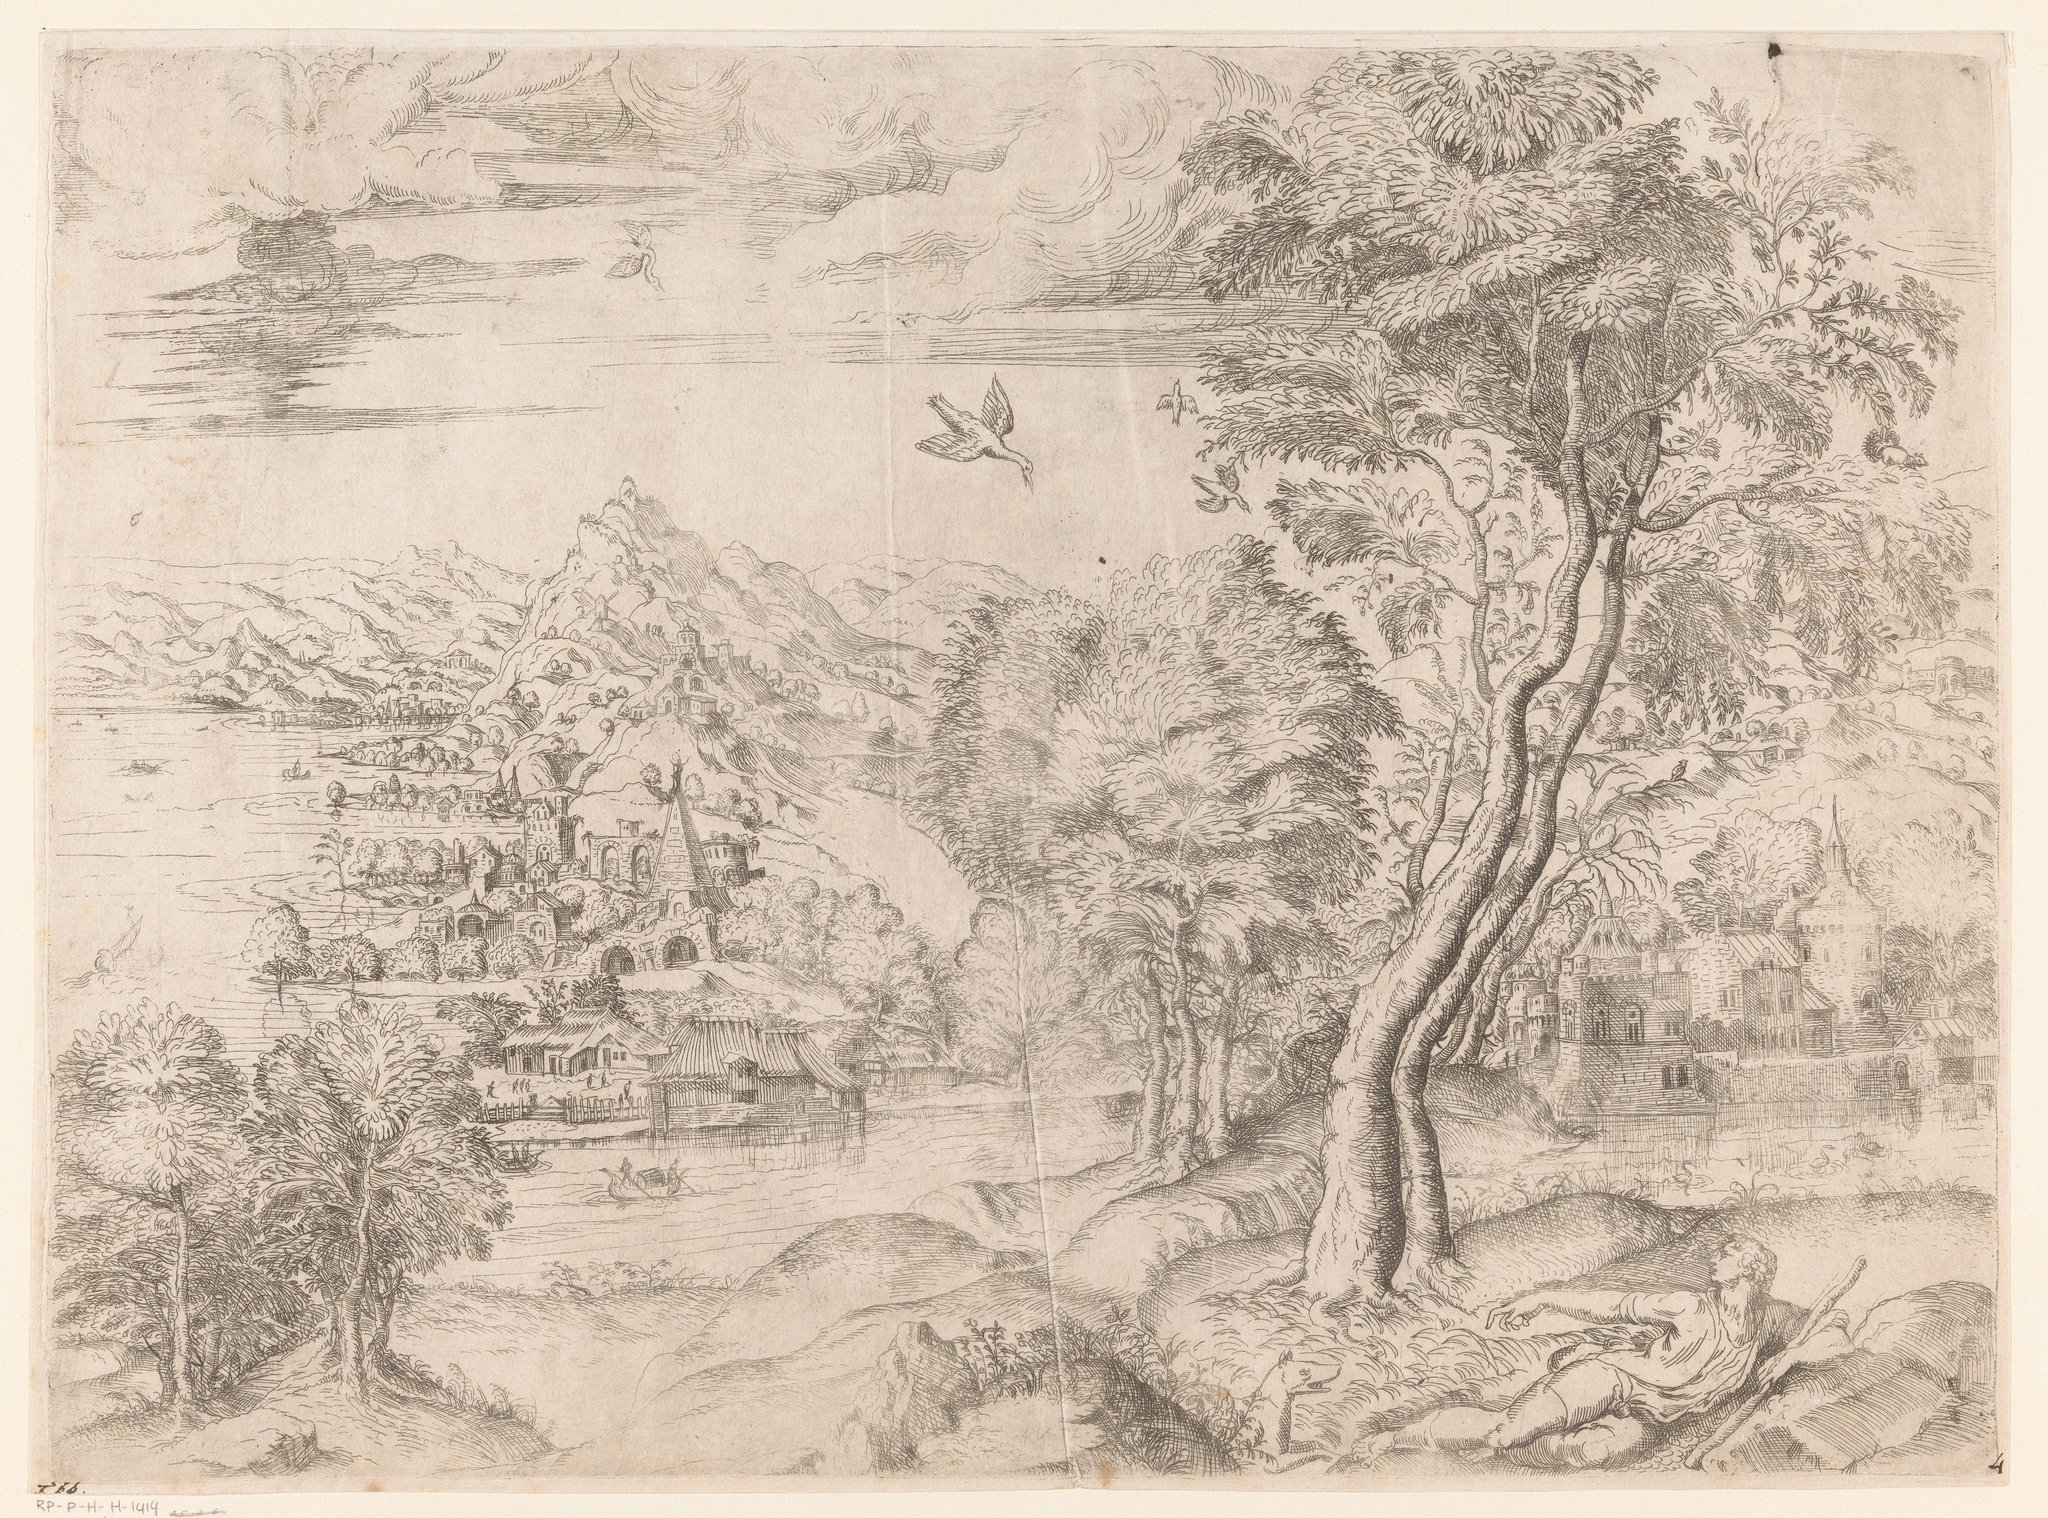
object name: print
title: Rivierlandschap met een herder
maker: Anonymous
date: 1498-1626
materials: paper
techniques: etching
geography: italy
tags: river, herding, herdsman, herdswoman, shepherd, shepherdess, cowherd, etc.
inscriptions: collector's mark: Lugt 11, number: ‘4’, inscription: ‘T. 66’, collector's mark: ‘Hinloopen’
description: Een rivierlandschap met rechts op de voorgrond een liggende herder met zijn hond. Aan de overzijde van de rivier liggen bergen en een stad.